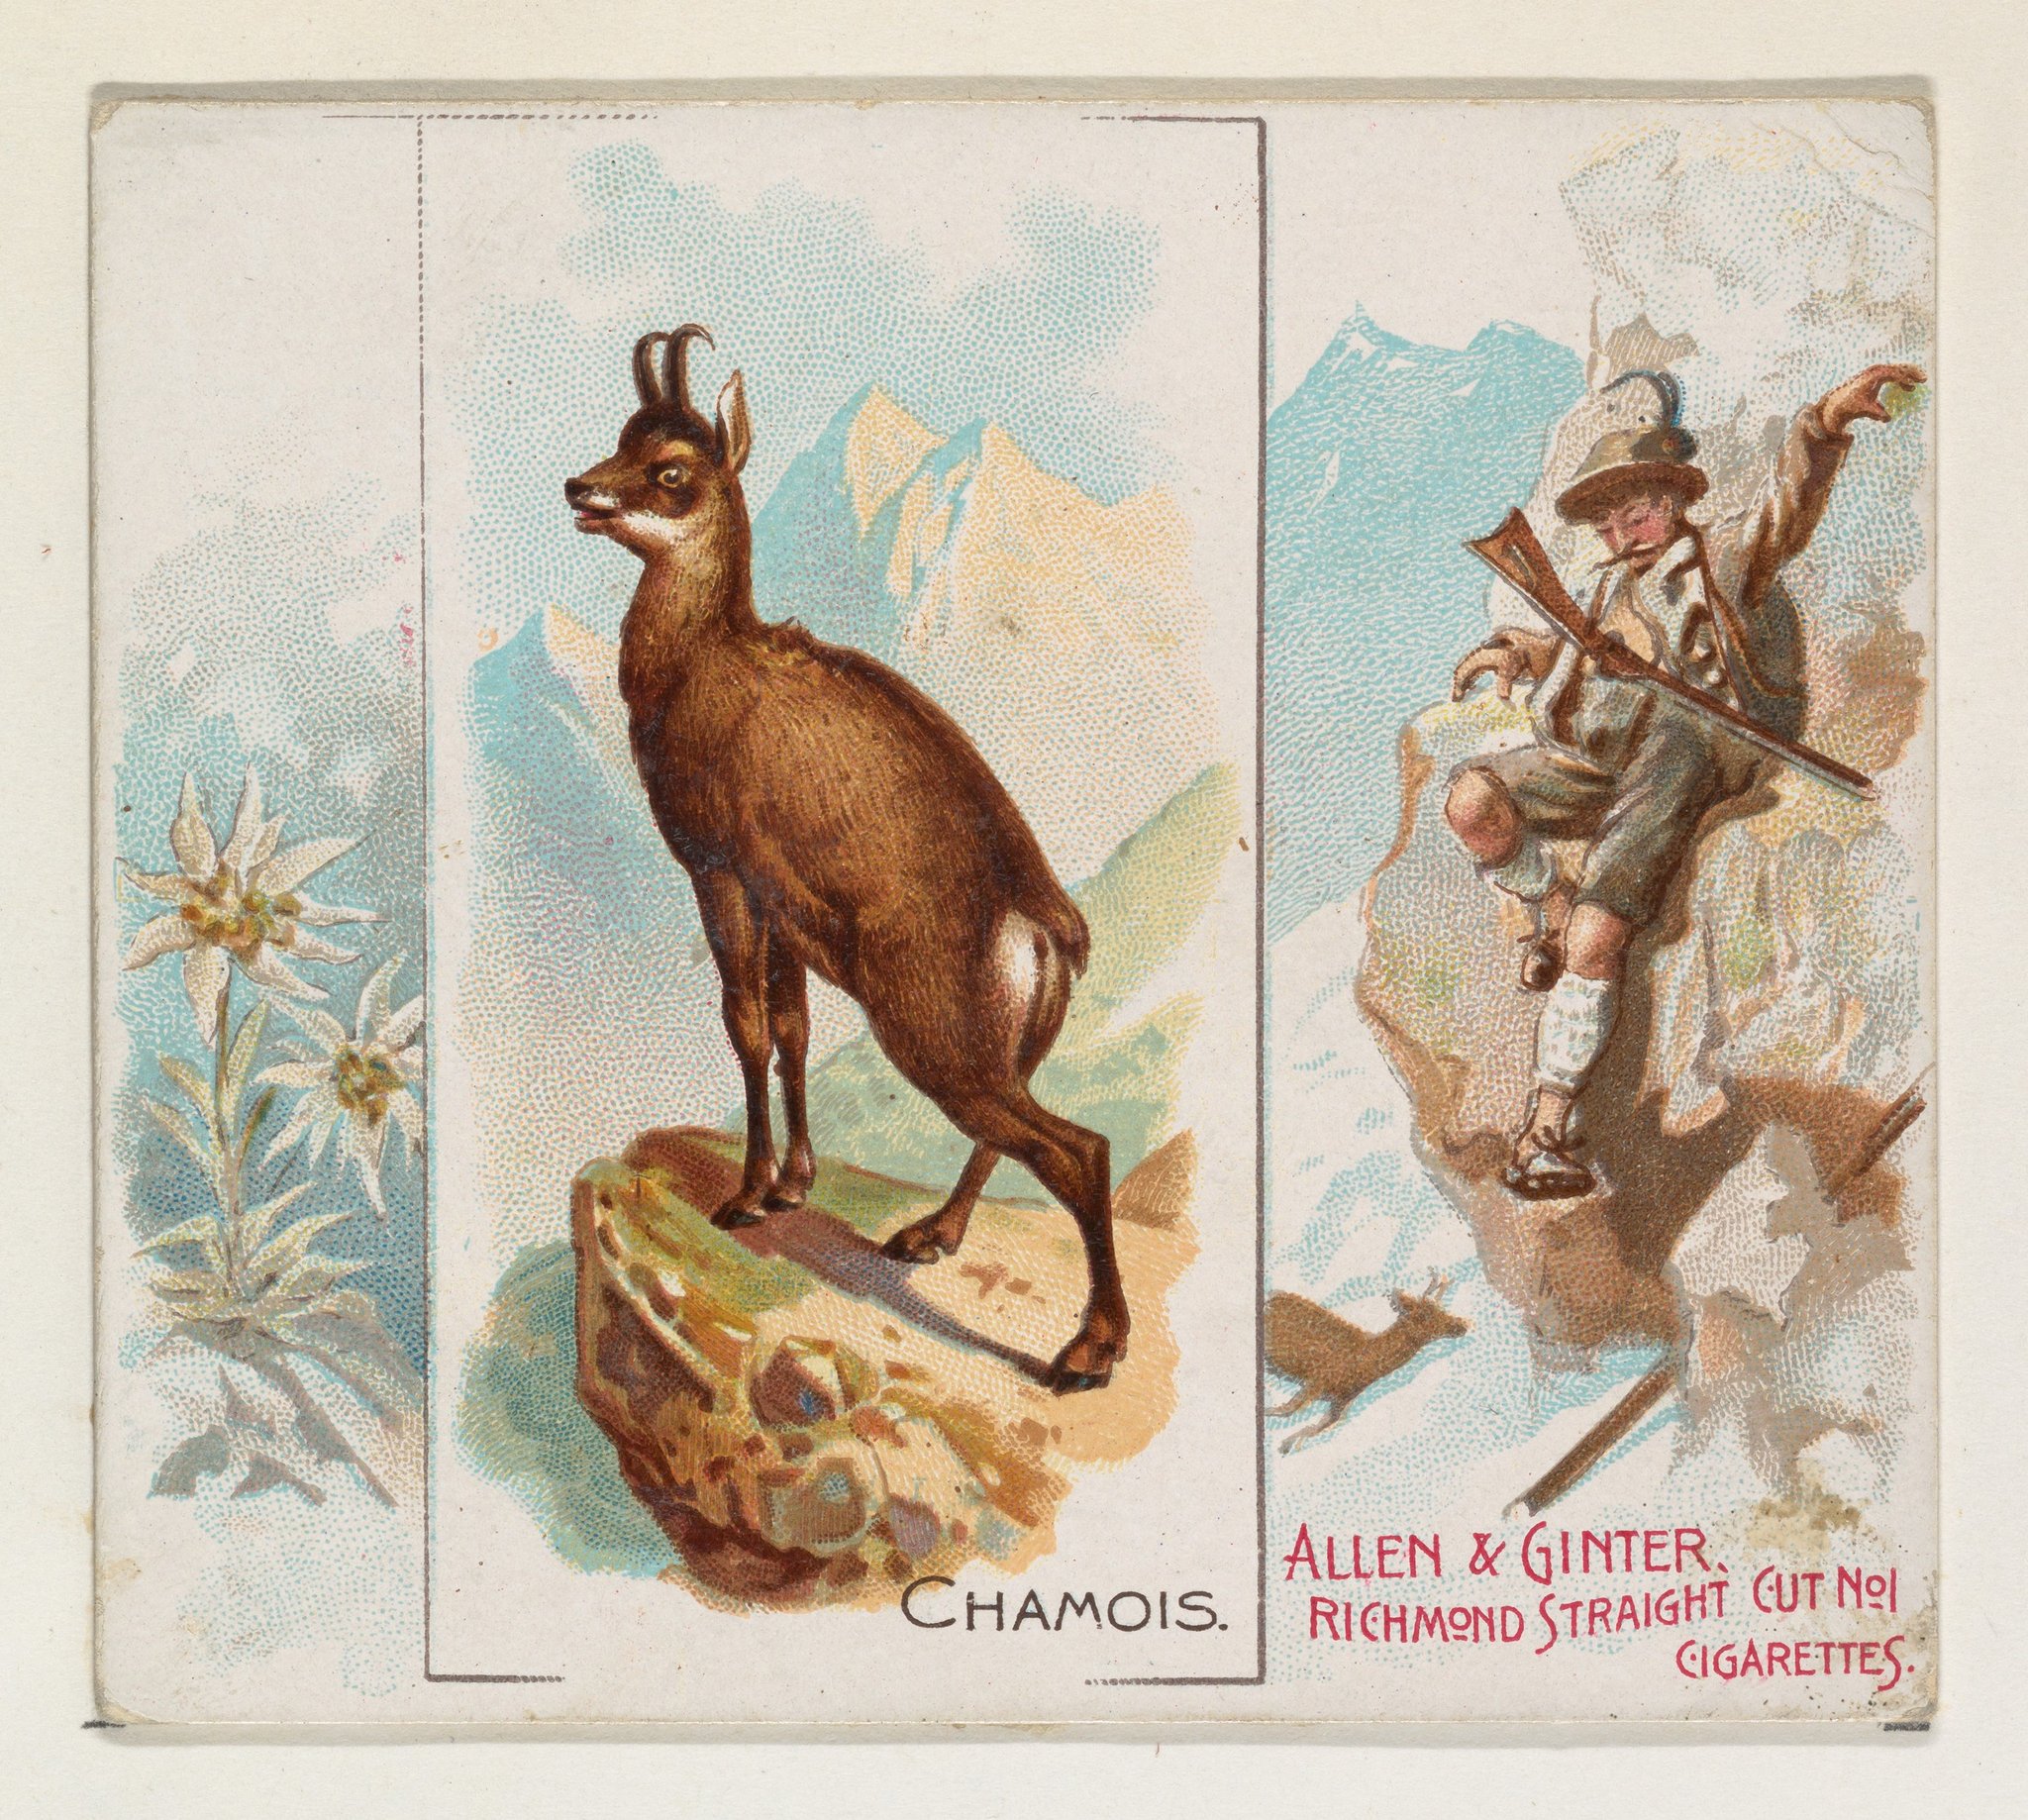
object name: print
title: Chamois, from Quadrupeds series (N41) for Allen & Ginter Cigarettes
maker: allen & ginter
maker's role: publisher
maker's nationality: american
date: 1890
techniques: color lithograph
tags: animals